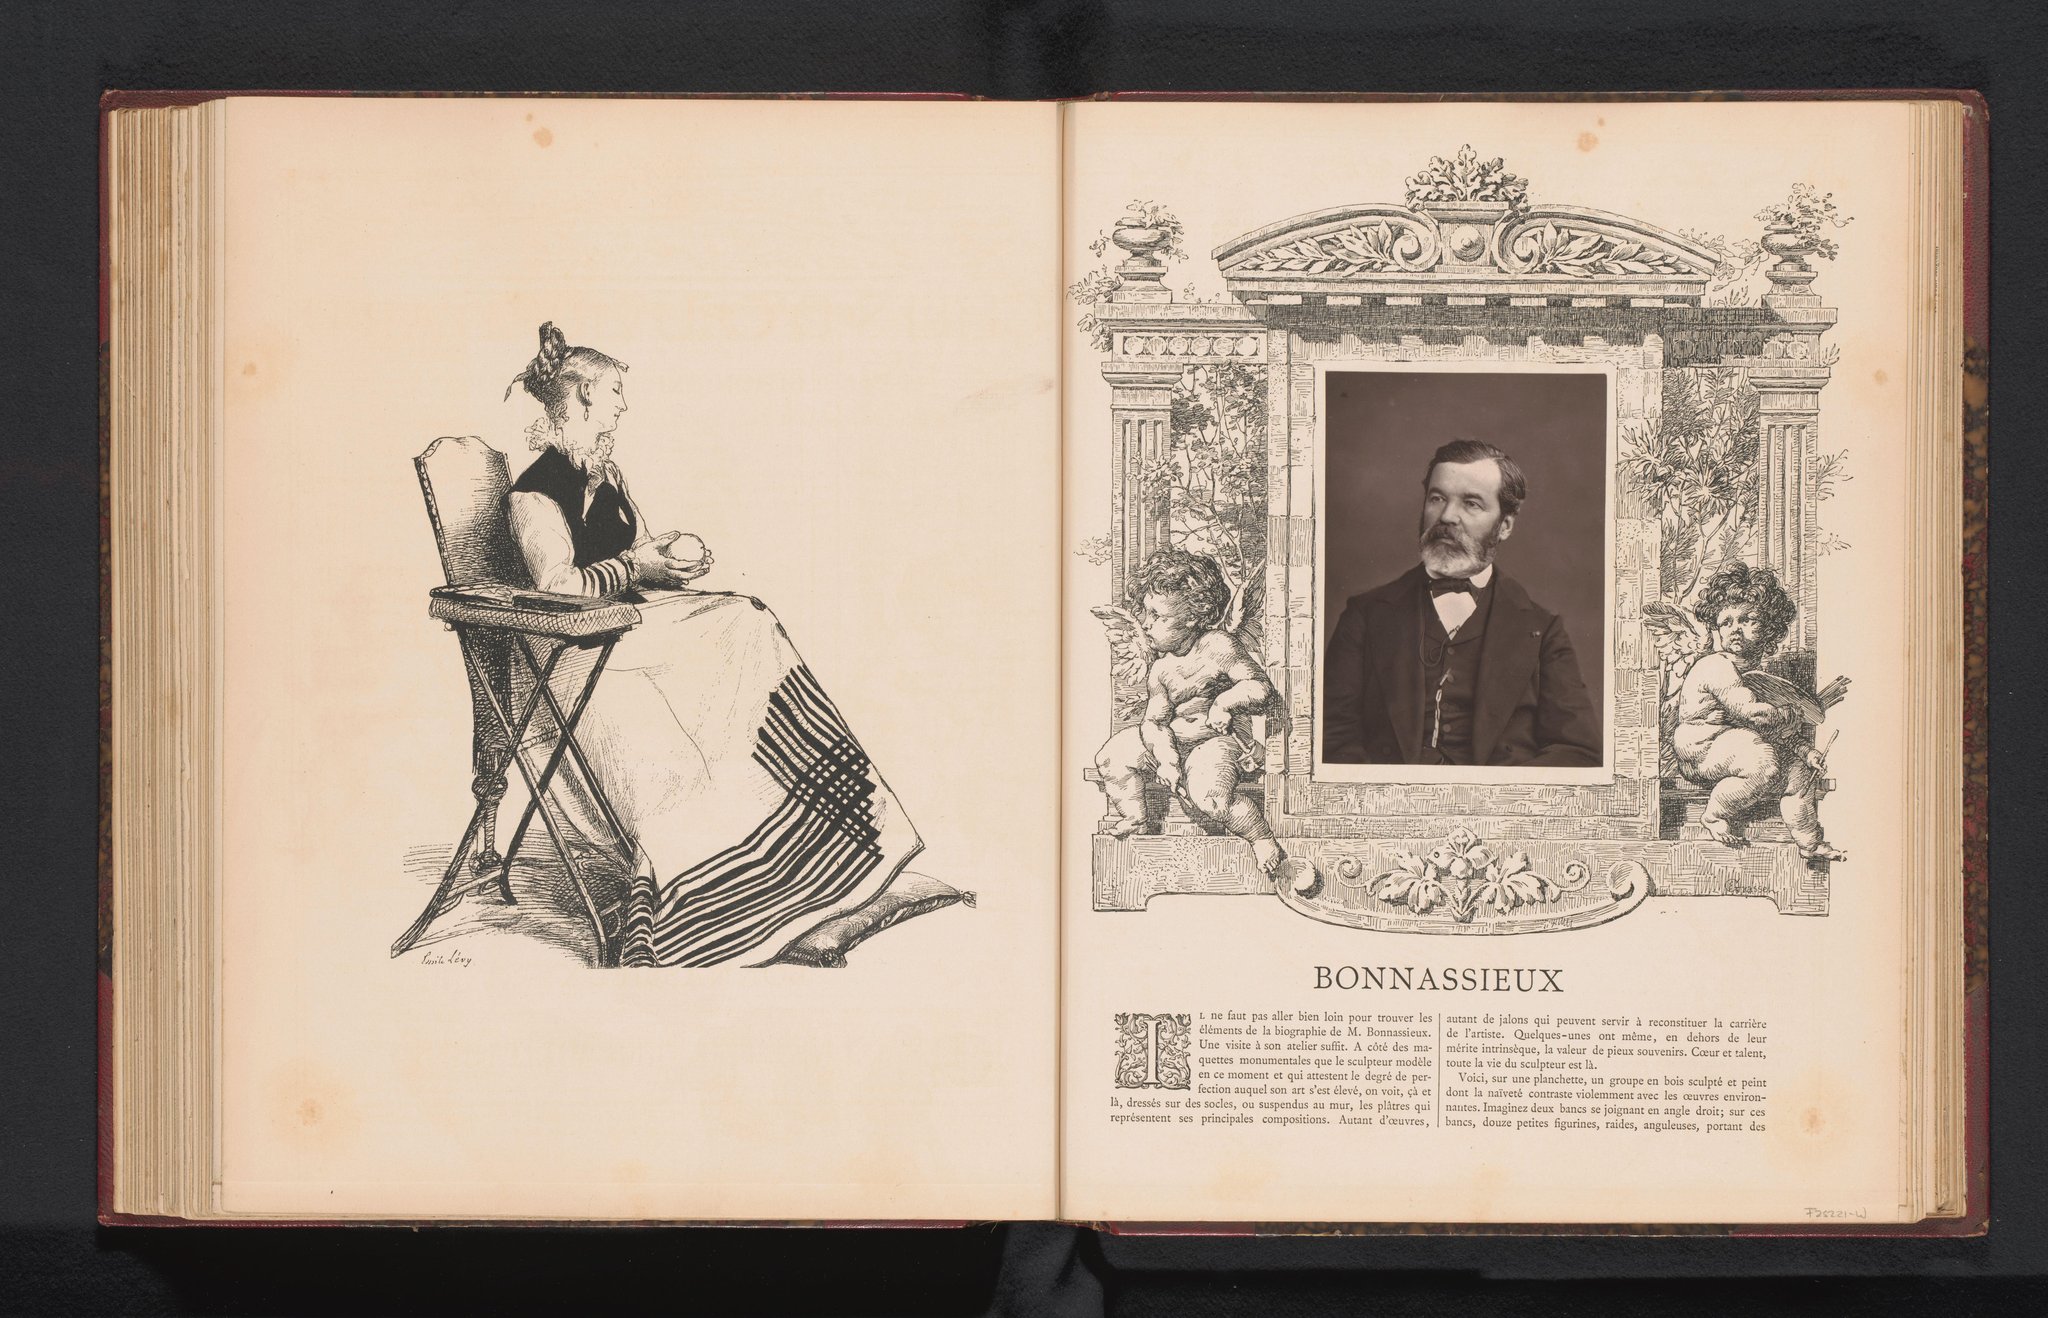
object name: photomechanical print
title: Portret van Jean-Marie Bonnassieux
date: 1867-1878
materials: paper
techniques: printing block, woodburytype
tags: jean-marie bonnassieux, adult man, historical persons